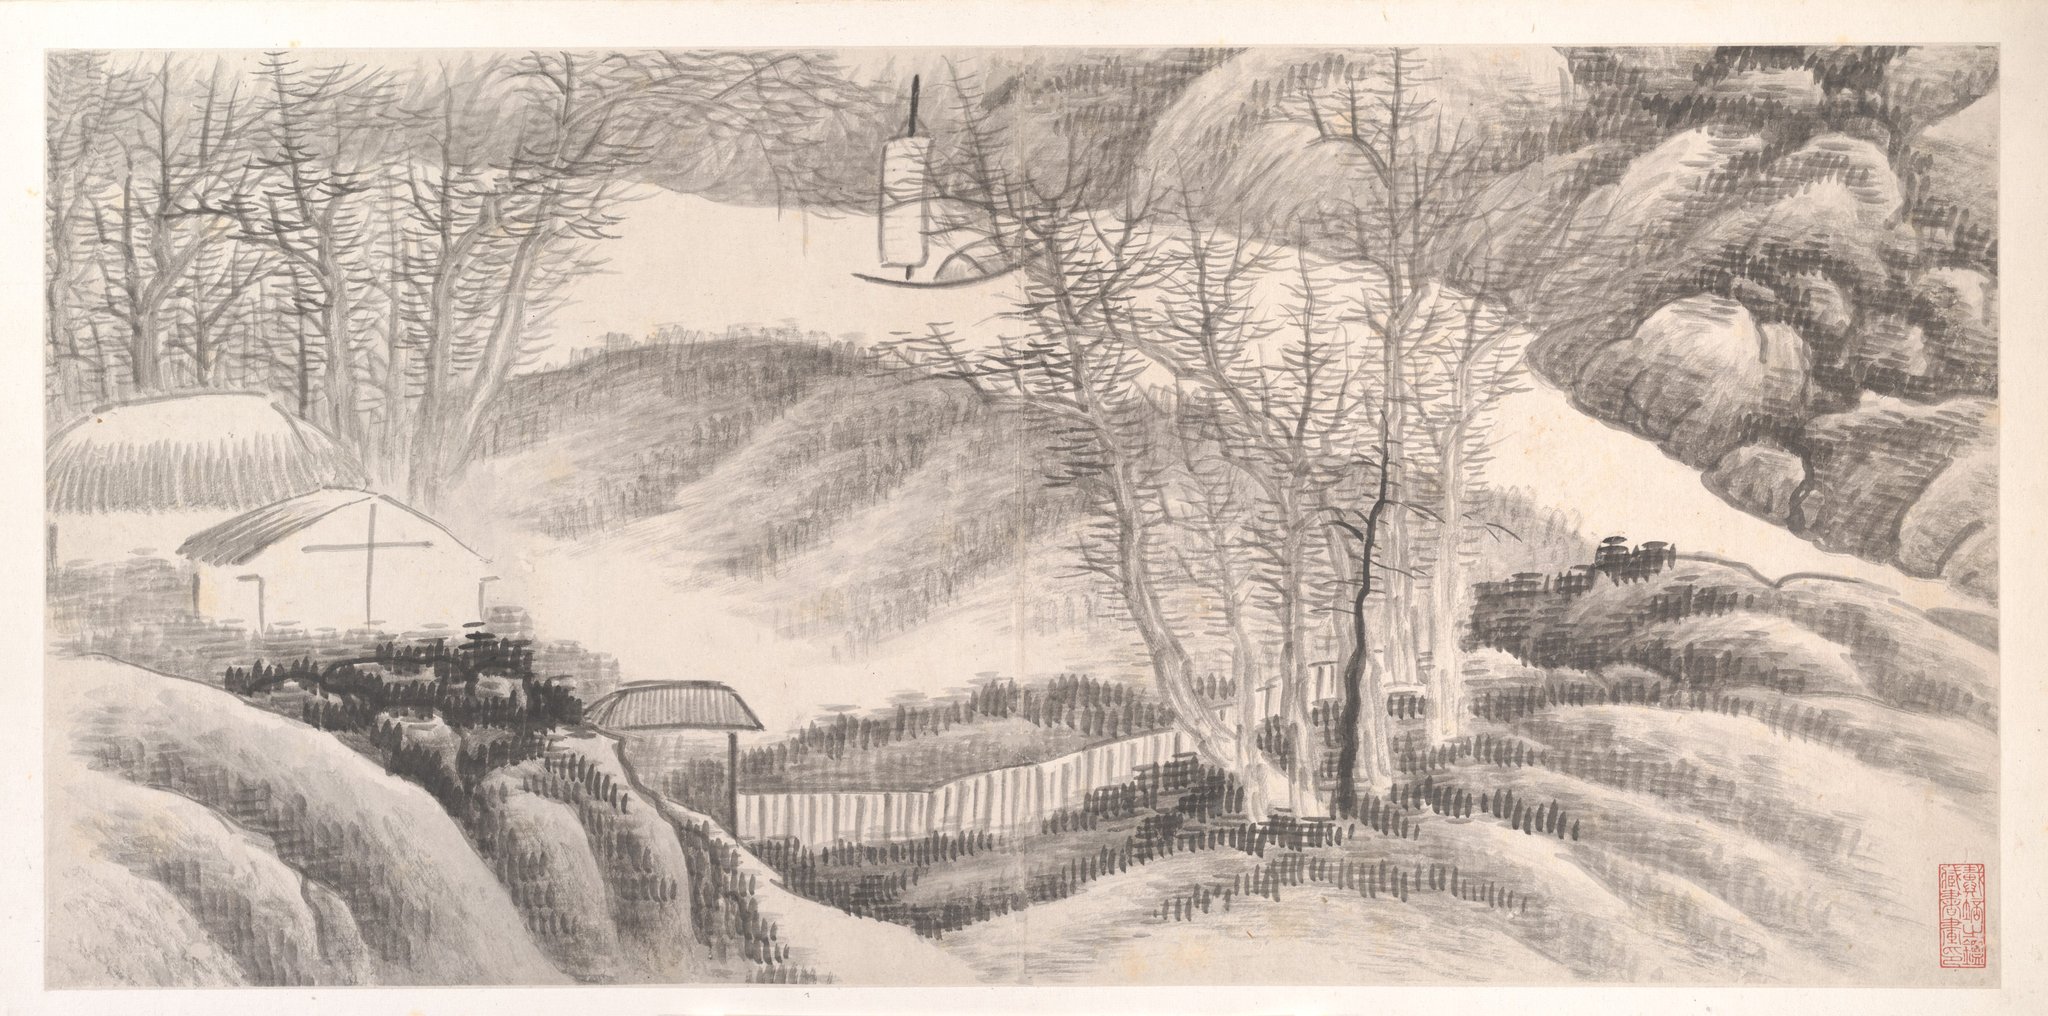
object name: album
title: Landscapes of the Twelve Months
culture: chinese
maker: gong xian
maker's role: artist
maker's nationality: chinese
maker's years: 1619-1689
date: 1685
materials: ink, paper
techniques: painting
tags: landscapes,boats